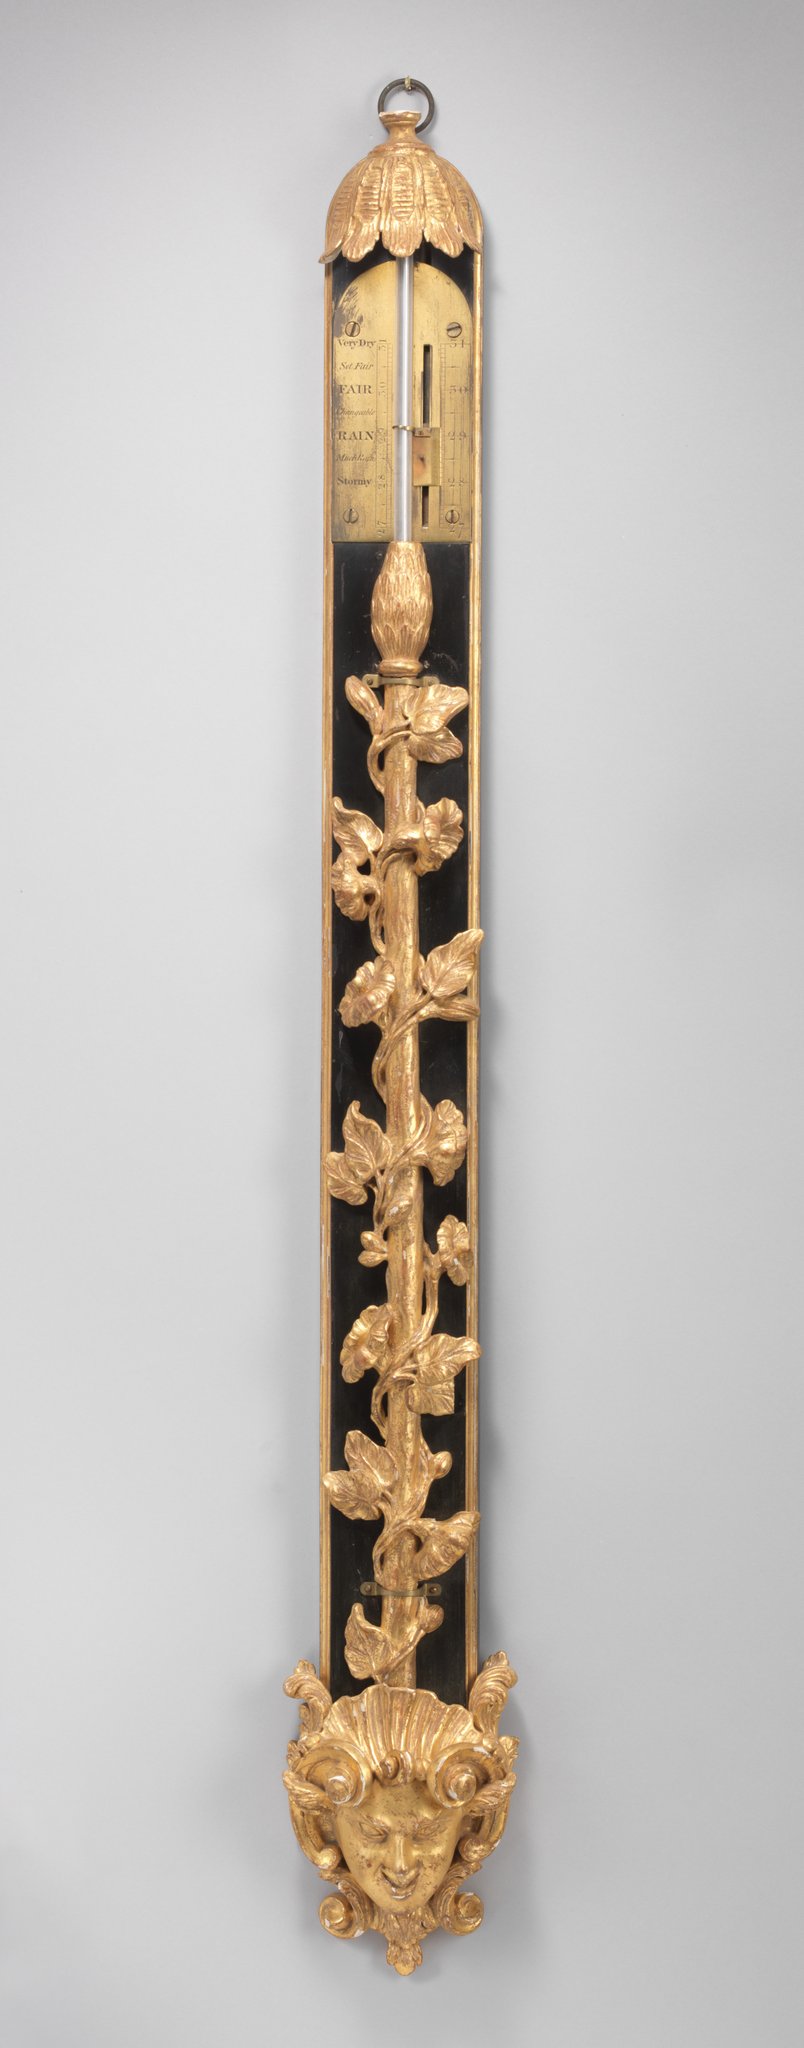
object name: torricellian barometer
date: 1745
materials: wood, gilt, mercury